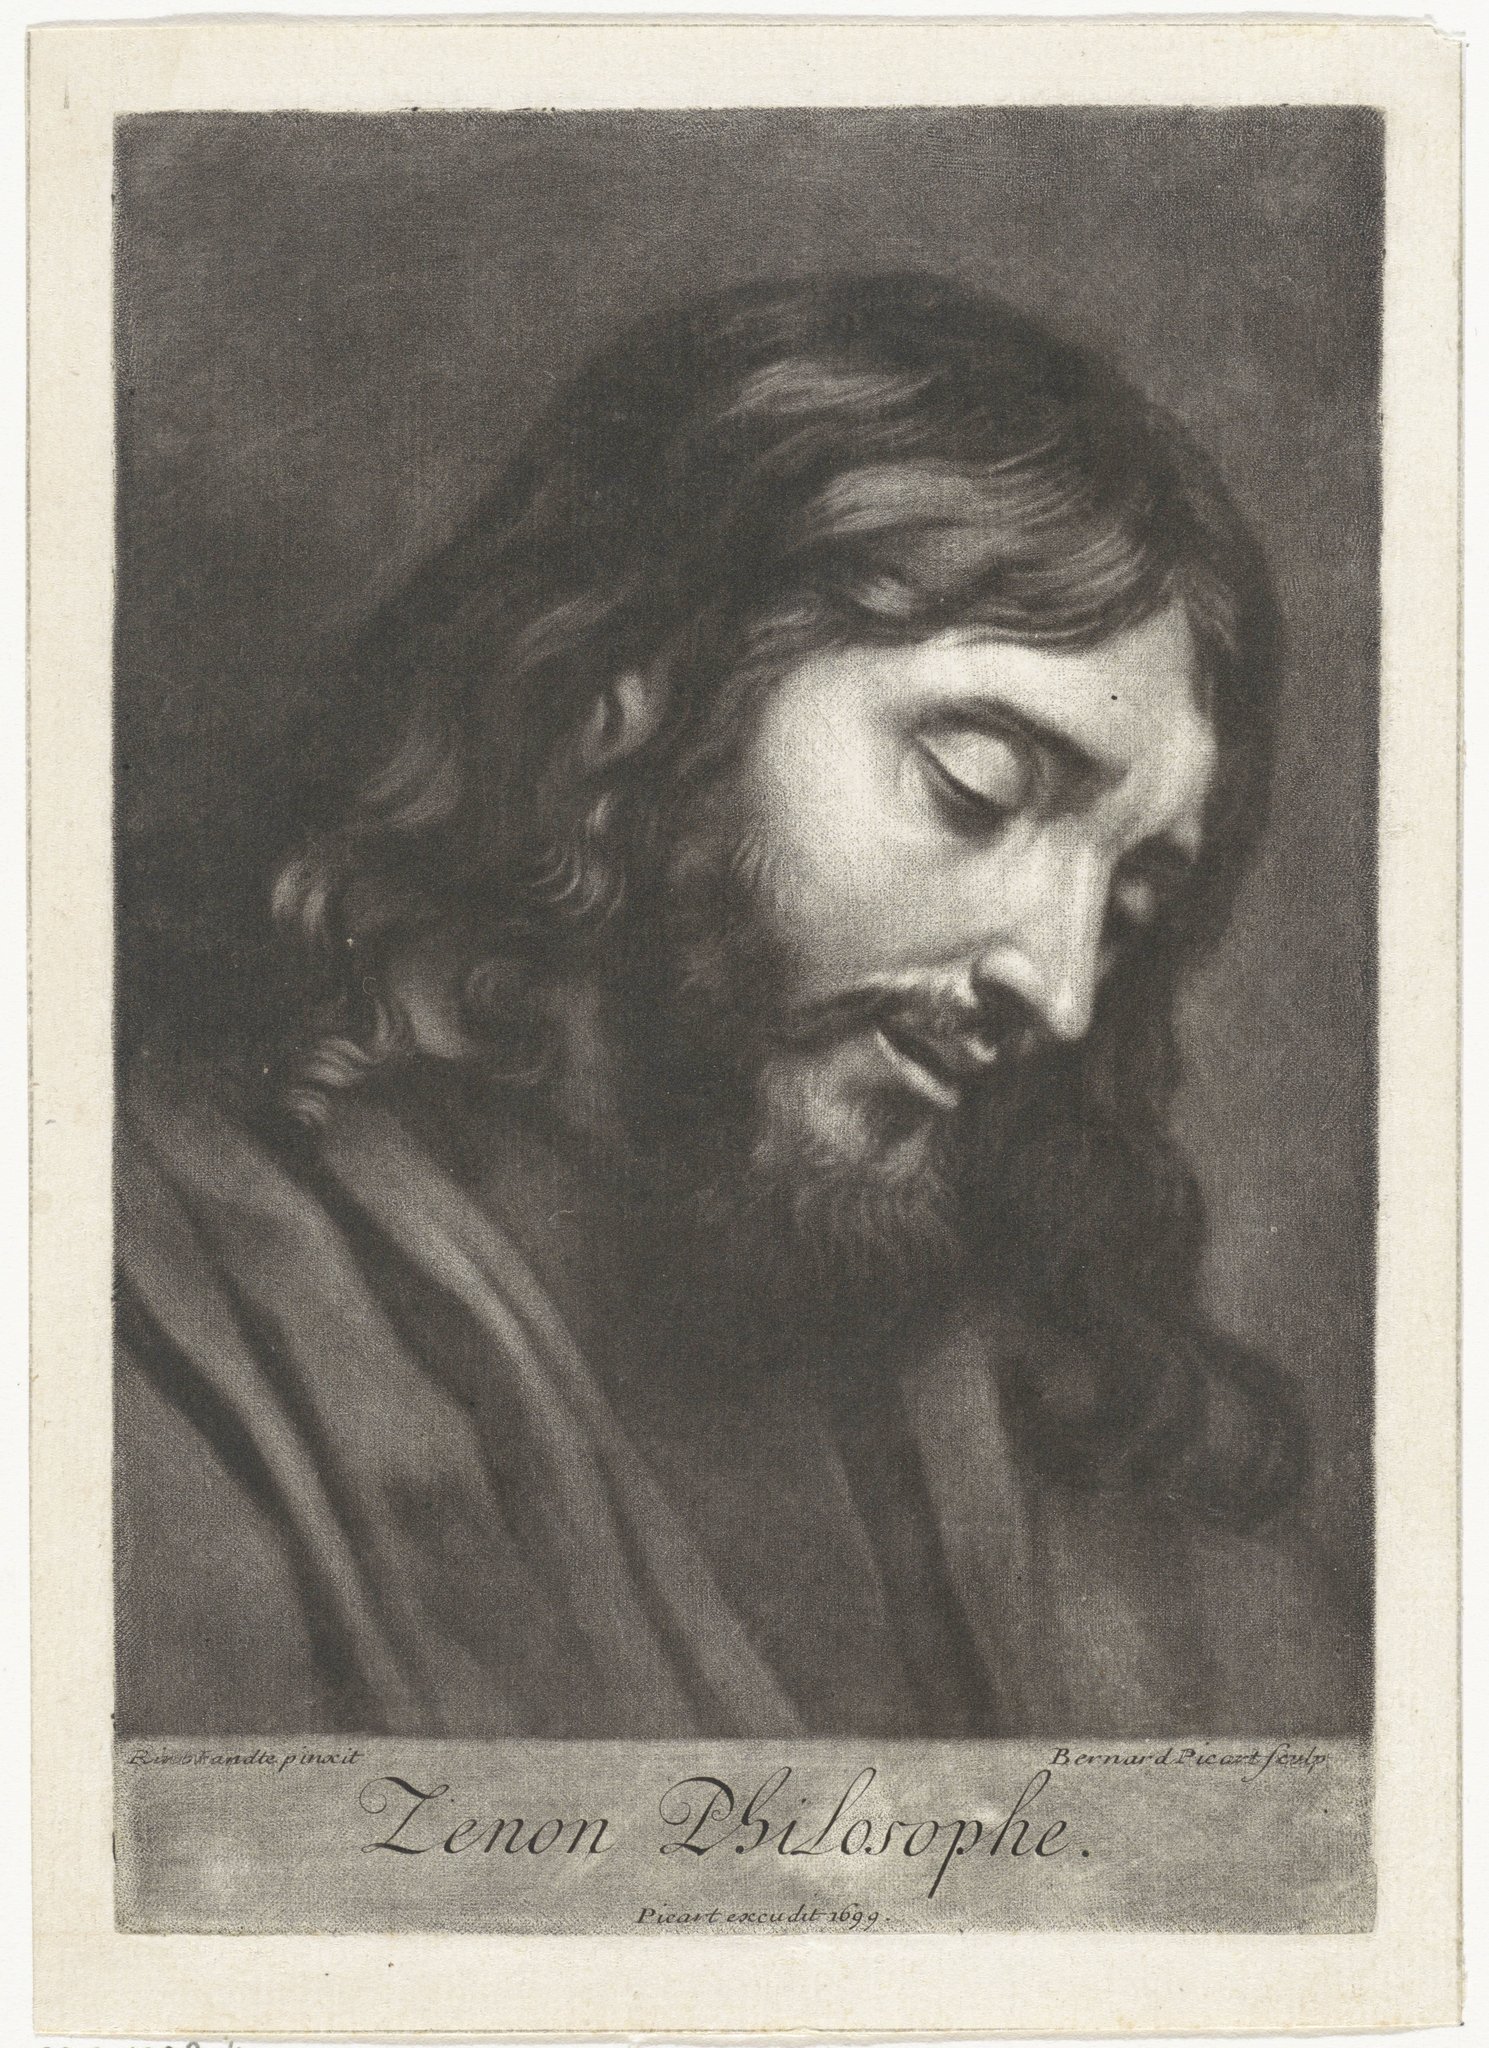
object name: print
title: Zenon Philosophe.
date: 1699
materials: paper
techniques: engraving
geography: paris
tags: schrijver, zeno van elea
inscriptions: collector's mark: Lugt 2228